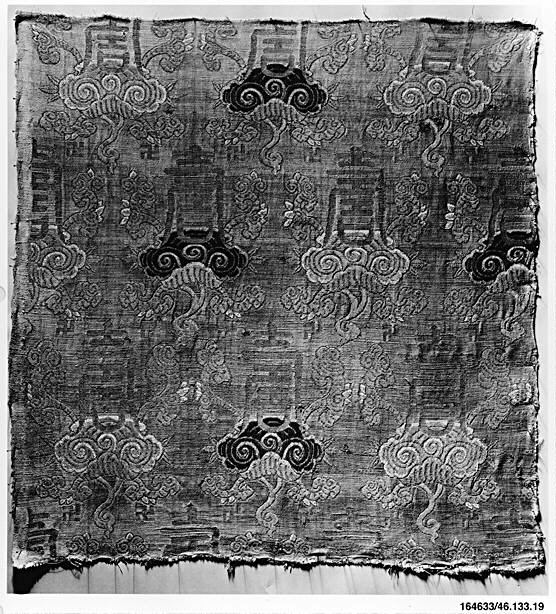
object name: piece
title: Panel with Shou Characters and Lingzhi Fungus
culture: chinese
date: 1501-1633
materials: silk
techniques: brocade, damask, weave